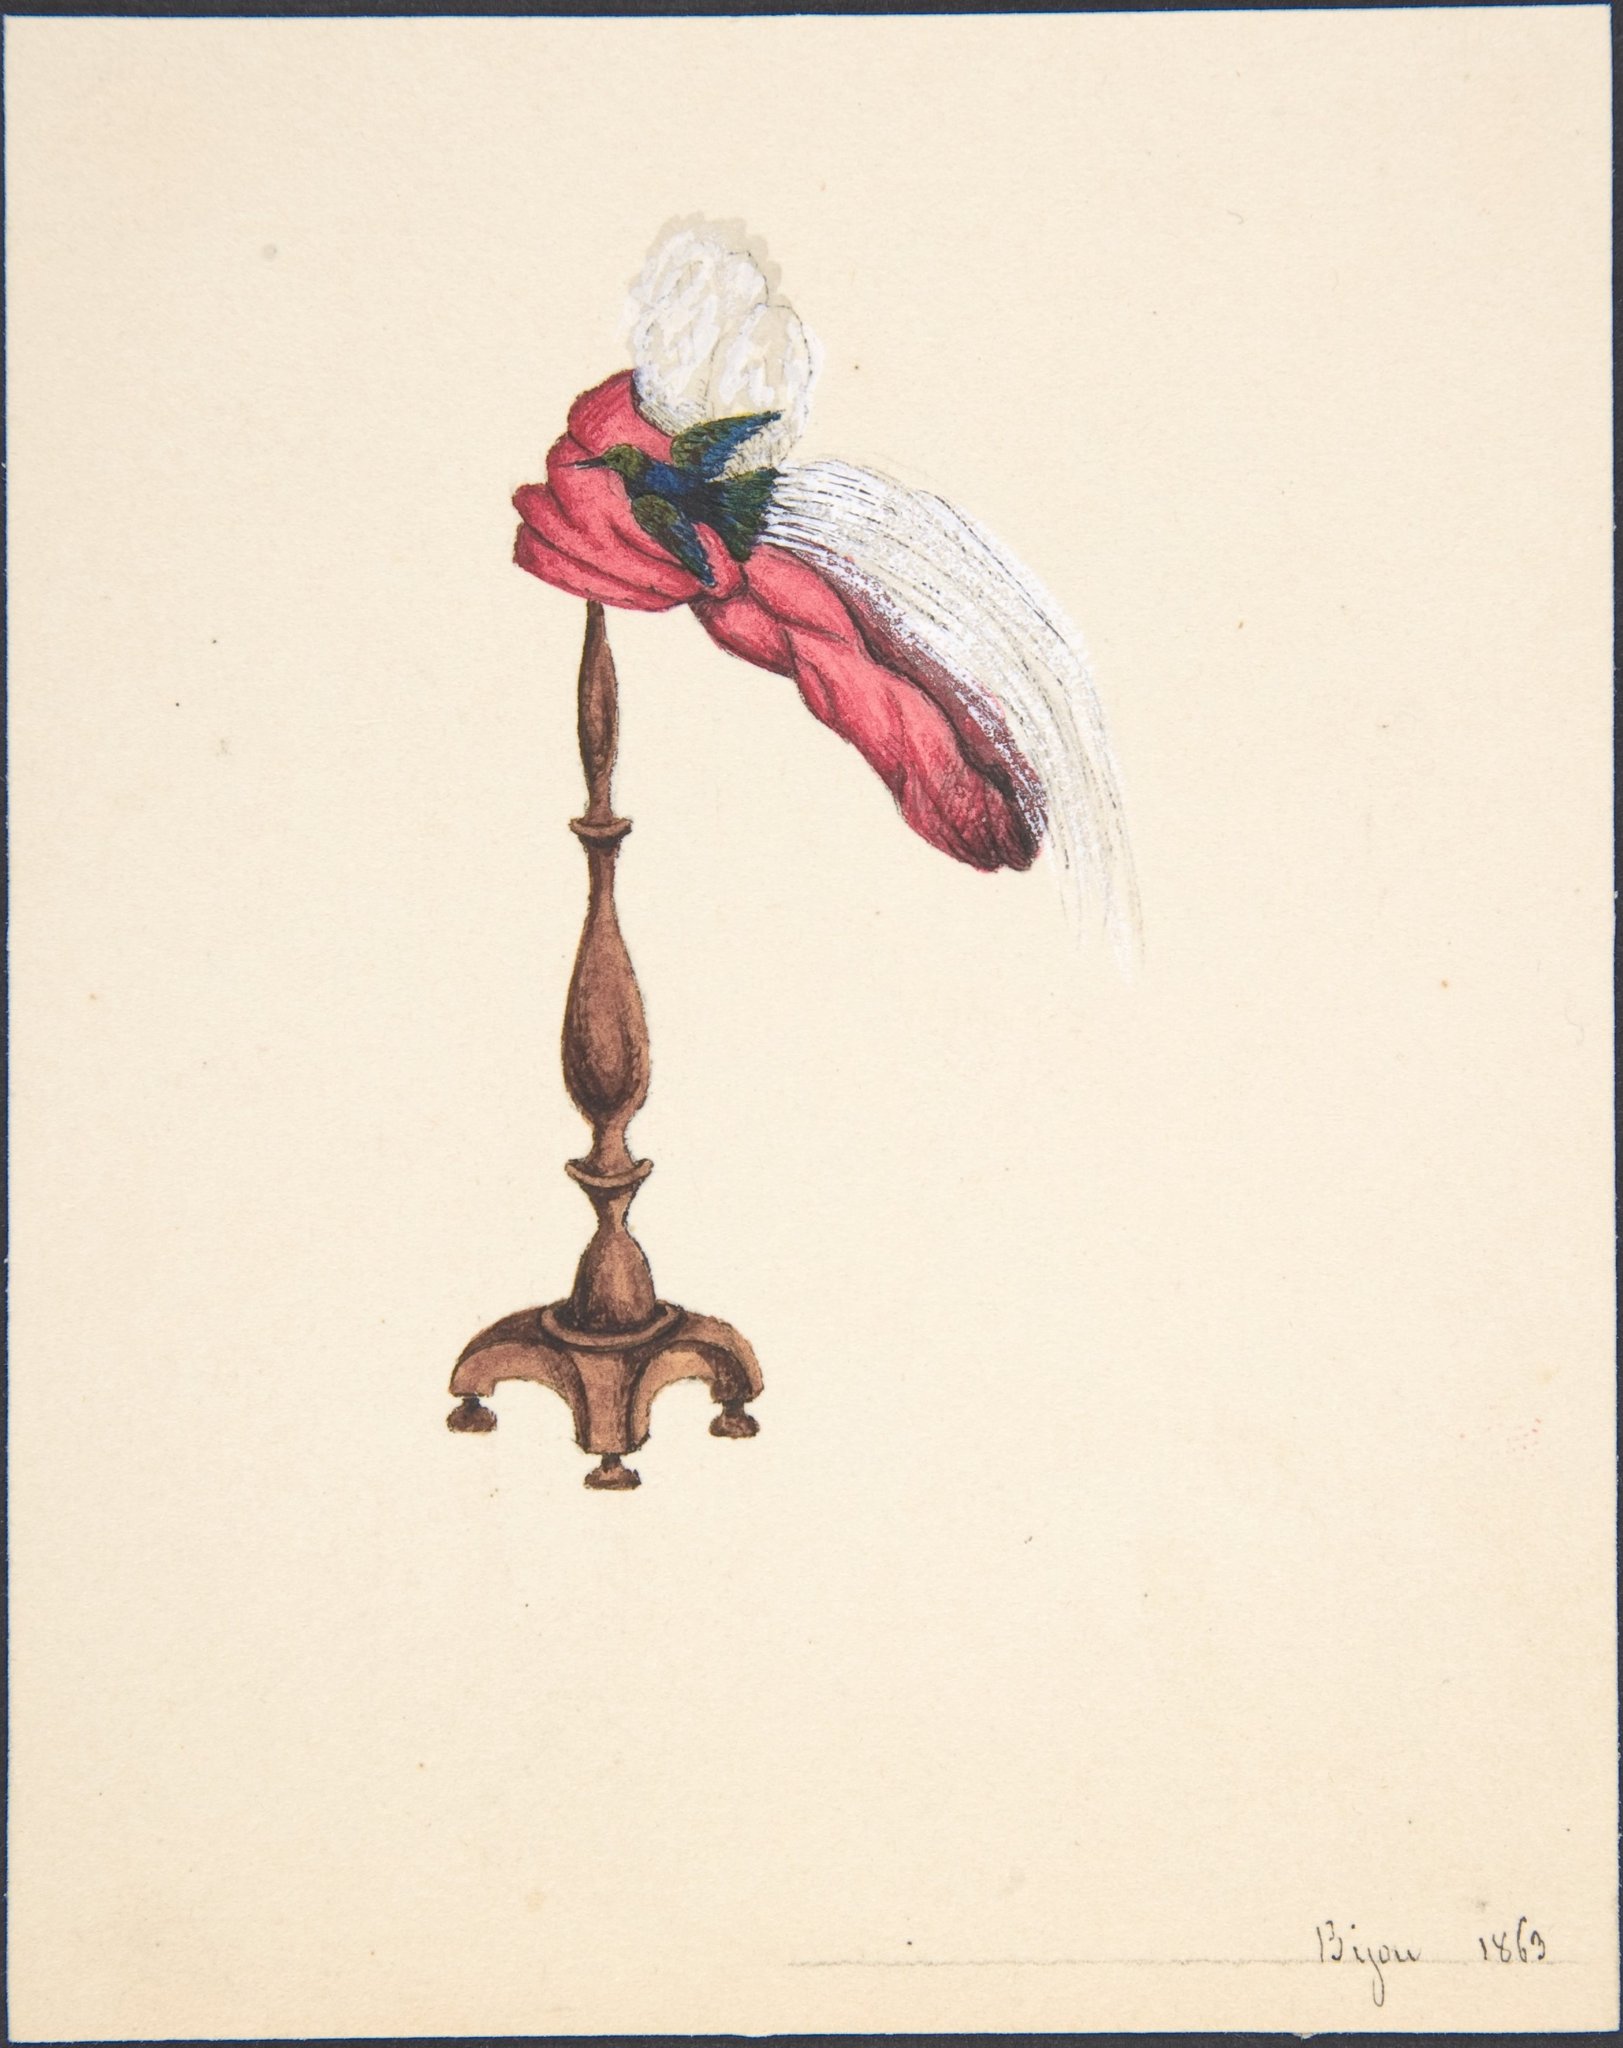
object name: drawing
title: A Hat on a Stand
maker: auguste félix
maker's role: artist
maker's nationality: french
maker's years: 1860-1870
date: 1863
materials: ink, watercolor, paper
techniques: brush, pen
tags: hats